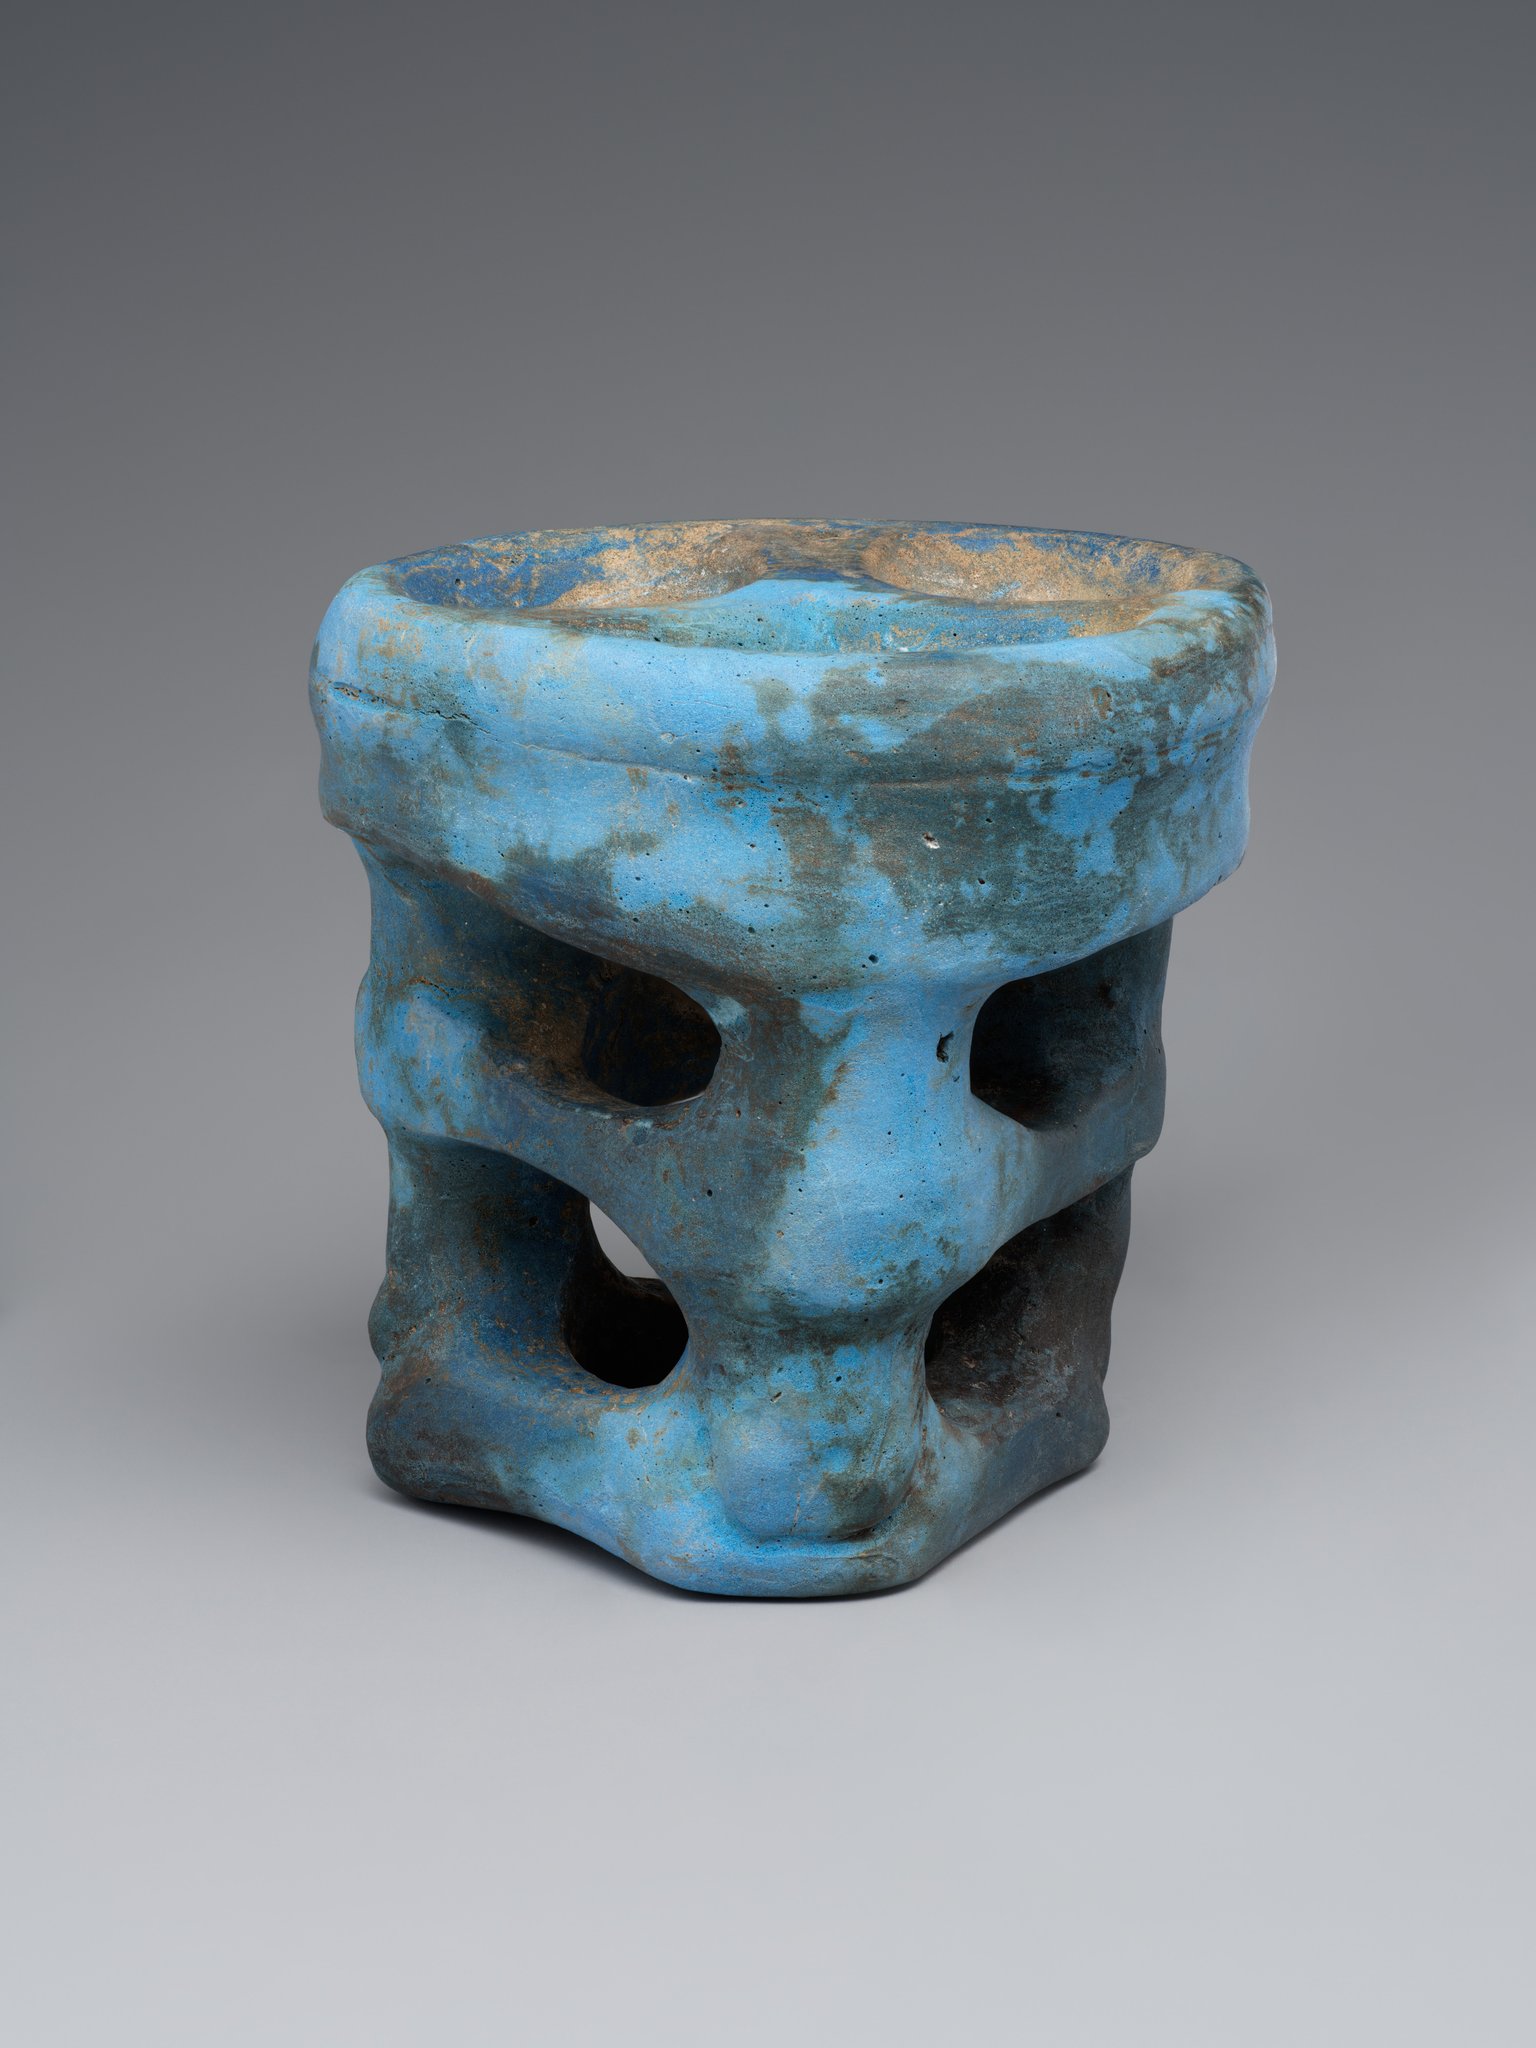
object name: cosmetic stand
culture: iranian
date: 900-801 BCE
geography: iran